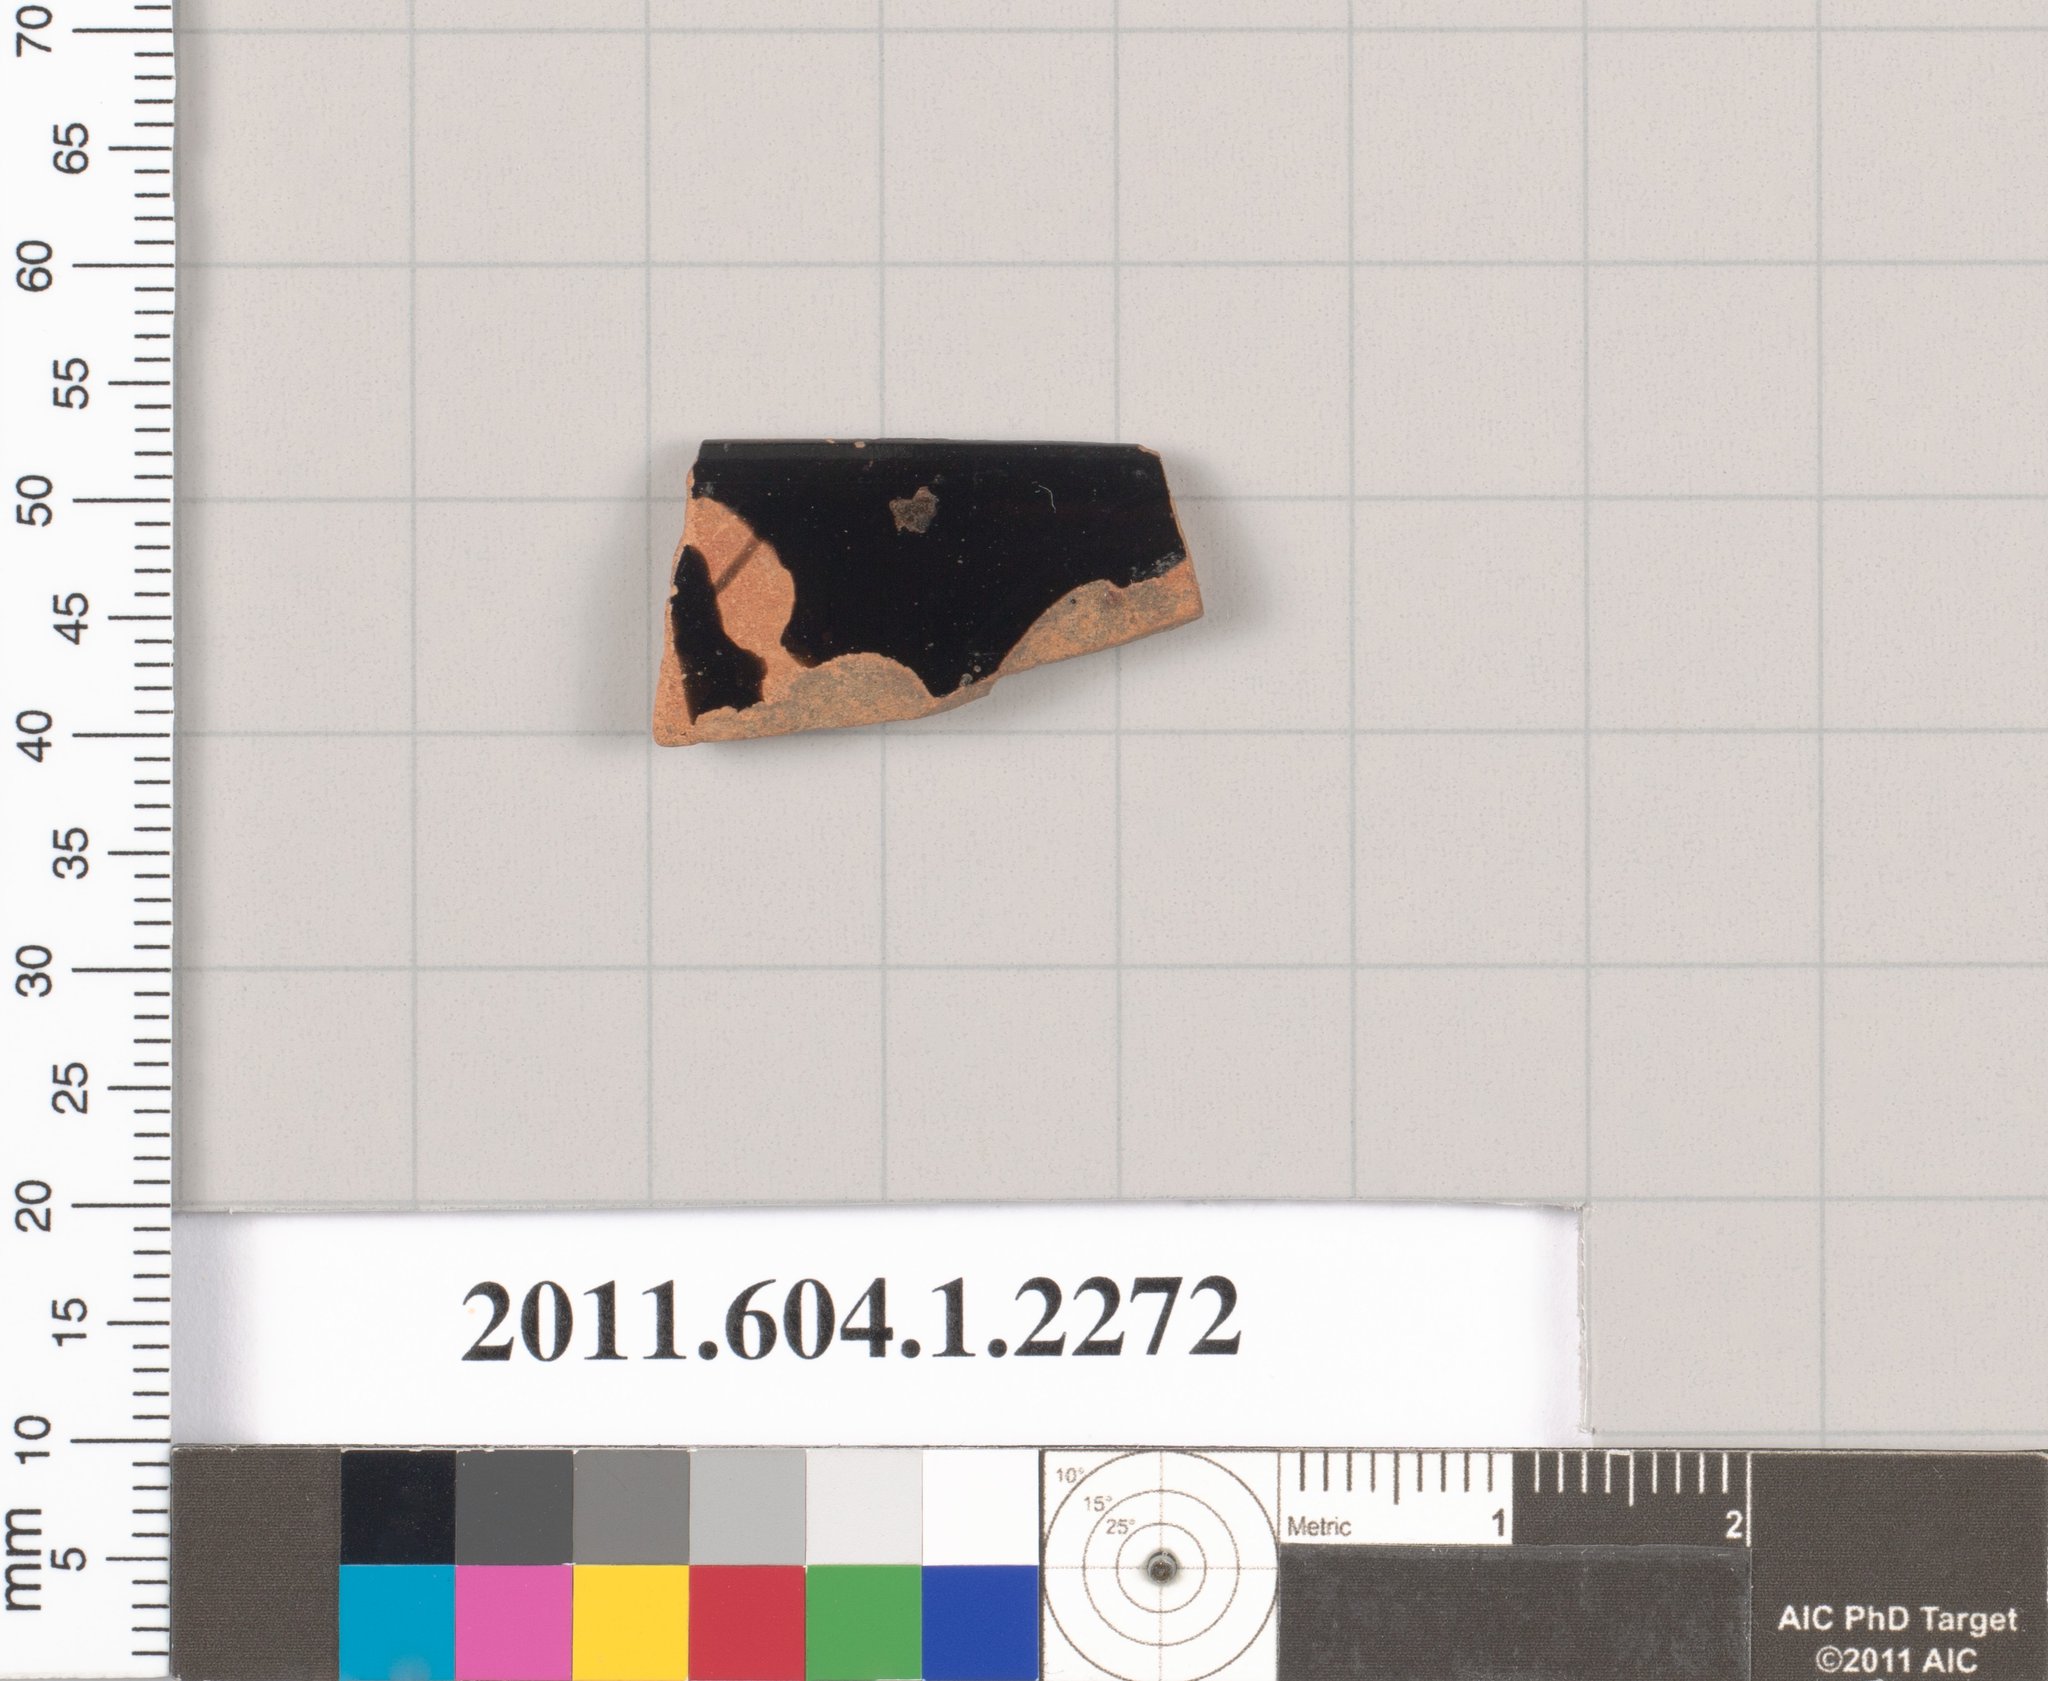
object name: kylix fragment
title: Terracotta rim fragment of a kylix (drinking cup)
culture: greek, attic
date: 467-435 BCE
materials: terracotta